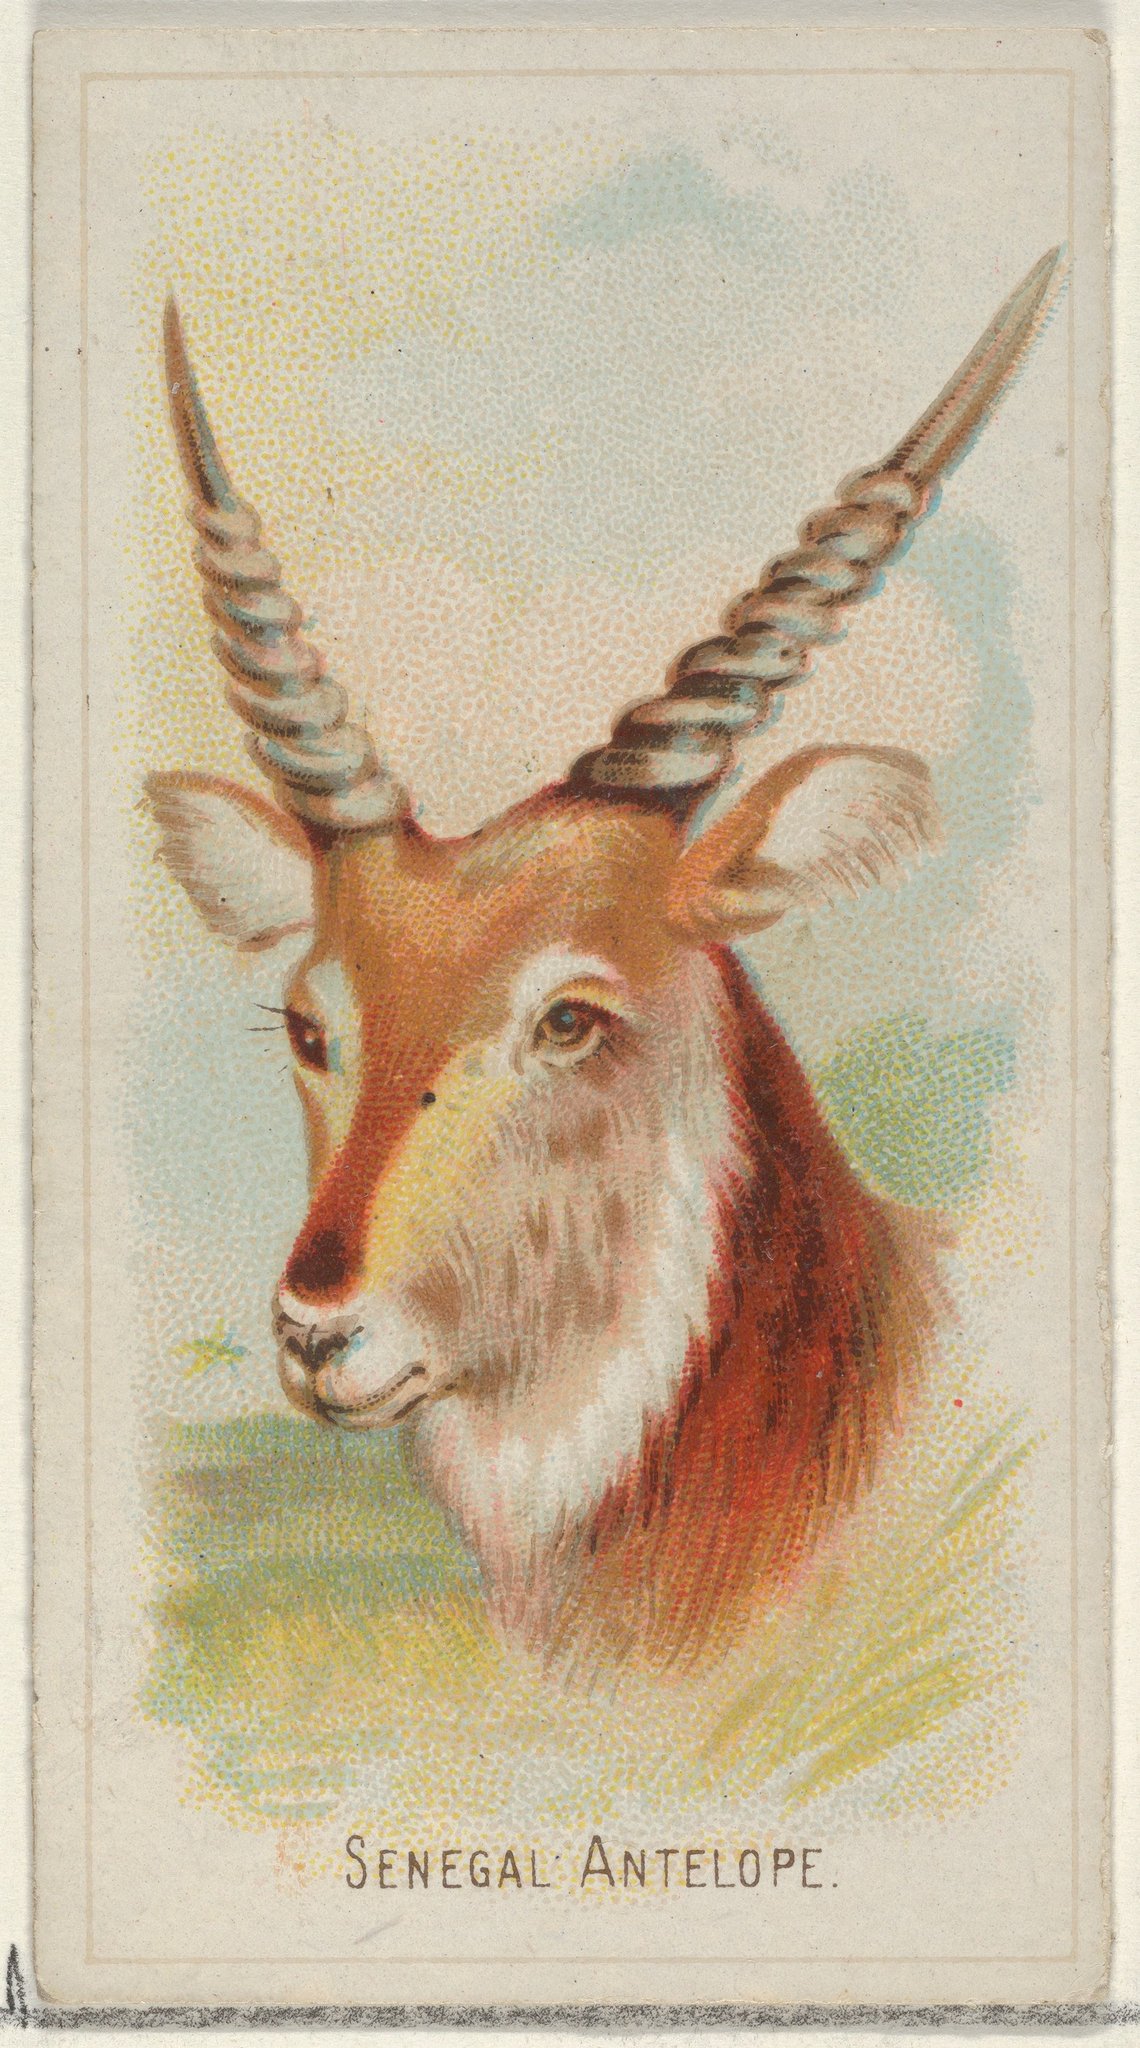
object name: print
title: Senegal Antelope, from the Wild Animals of the World series (N25) for Allen & Ginter Cigarettes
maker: allen & ginter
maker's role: publisher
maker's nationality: american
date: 1888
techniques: color lithograph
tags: antelope